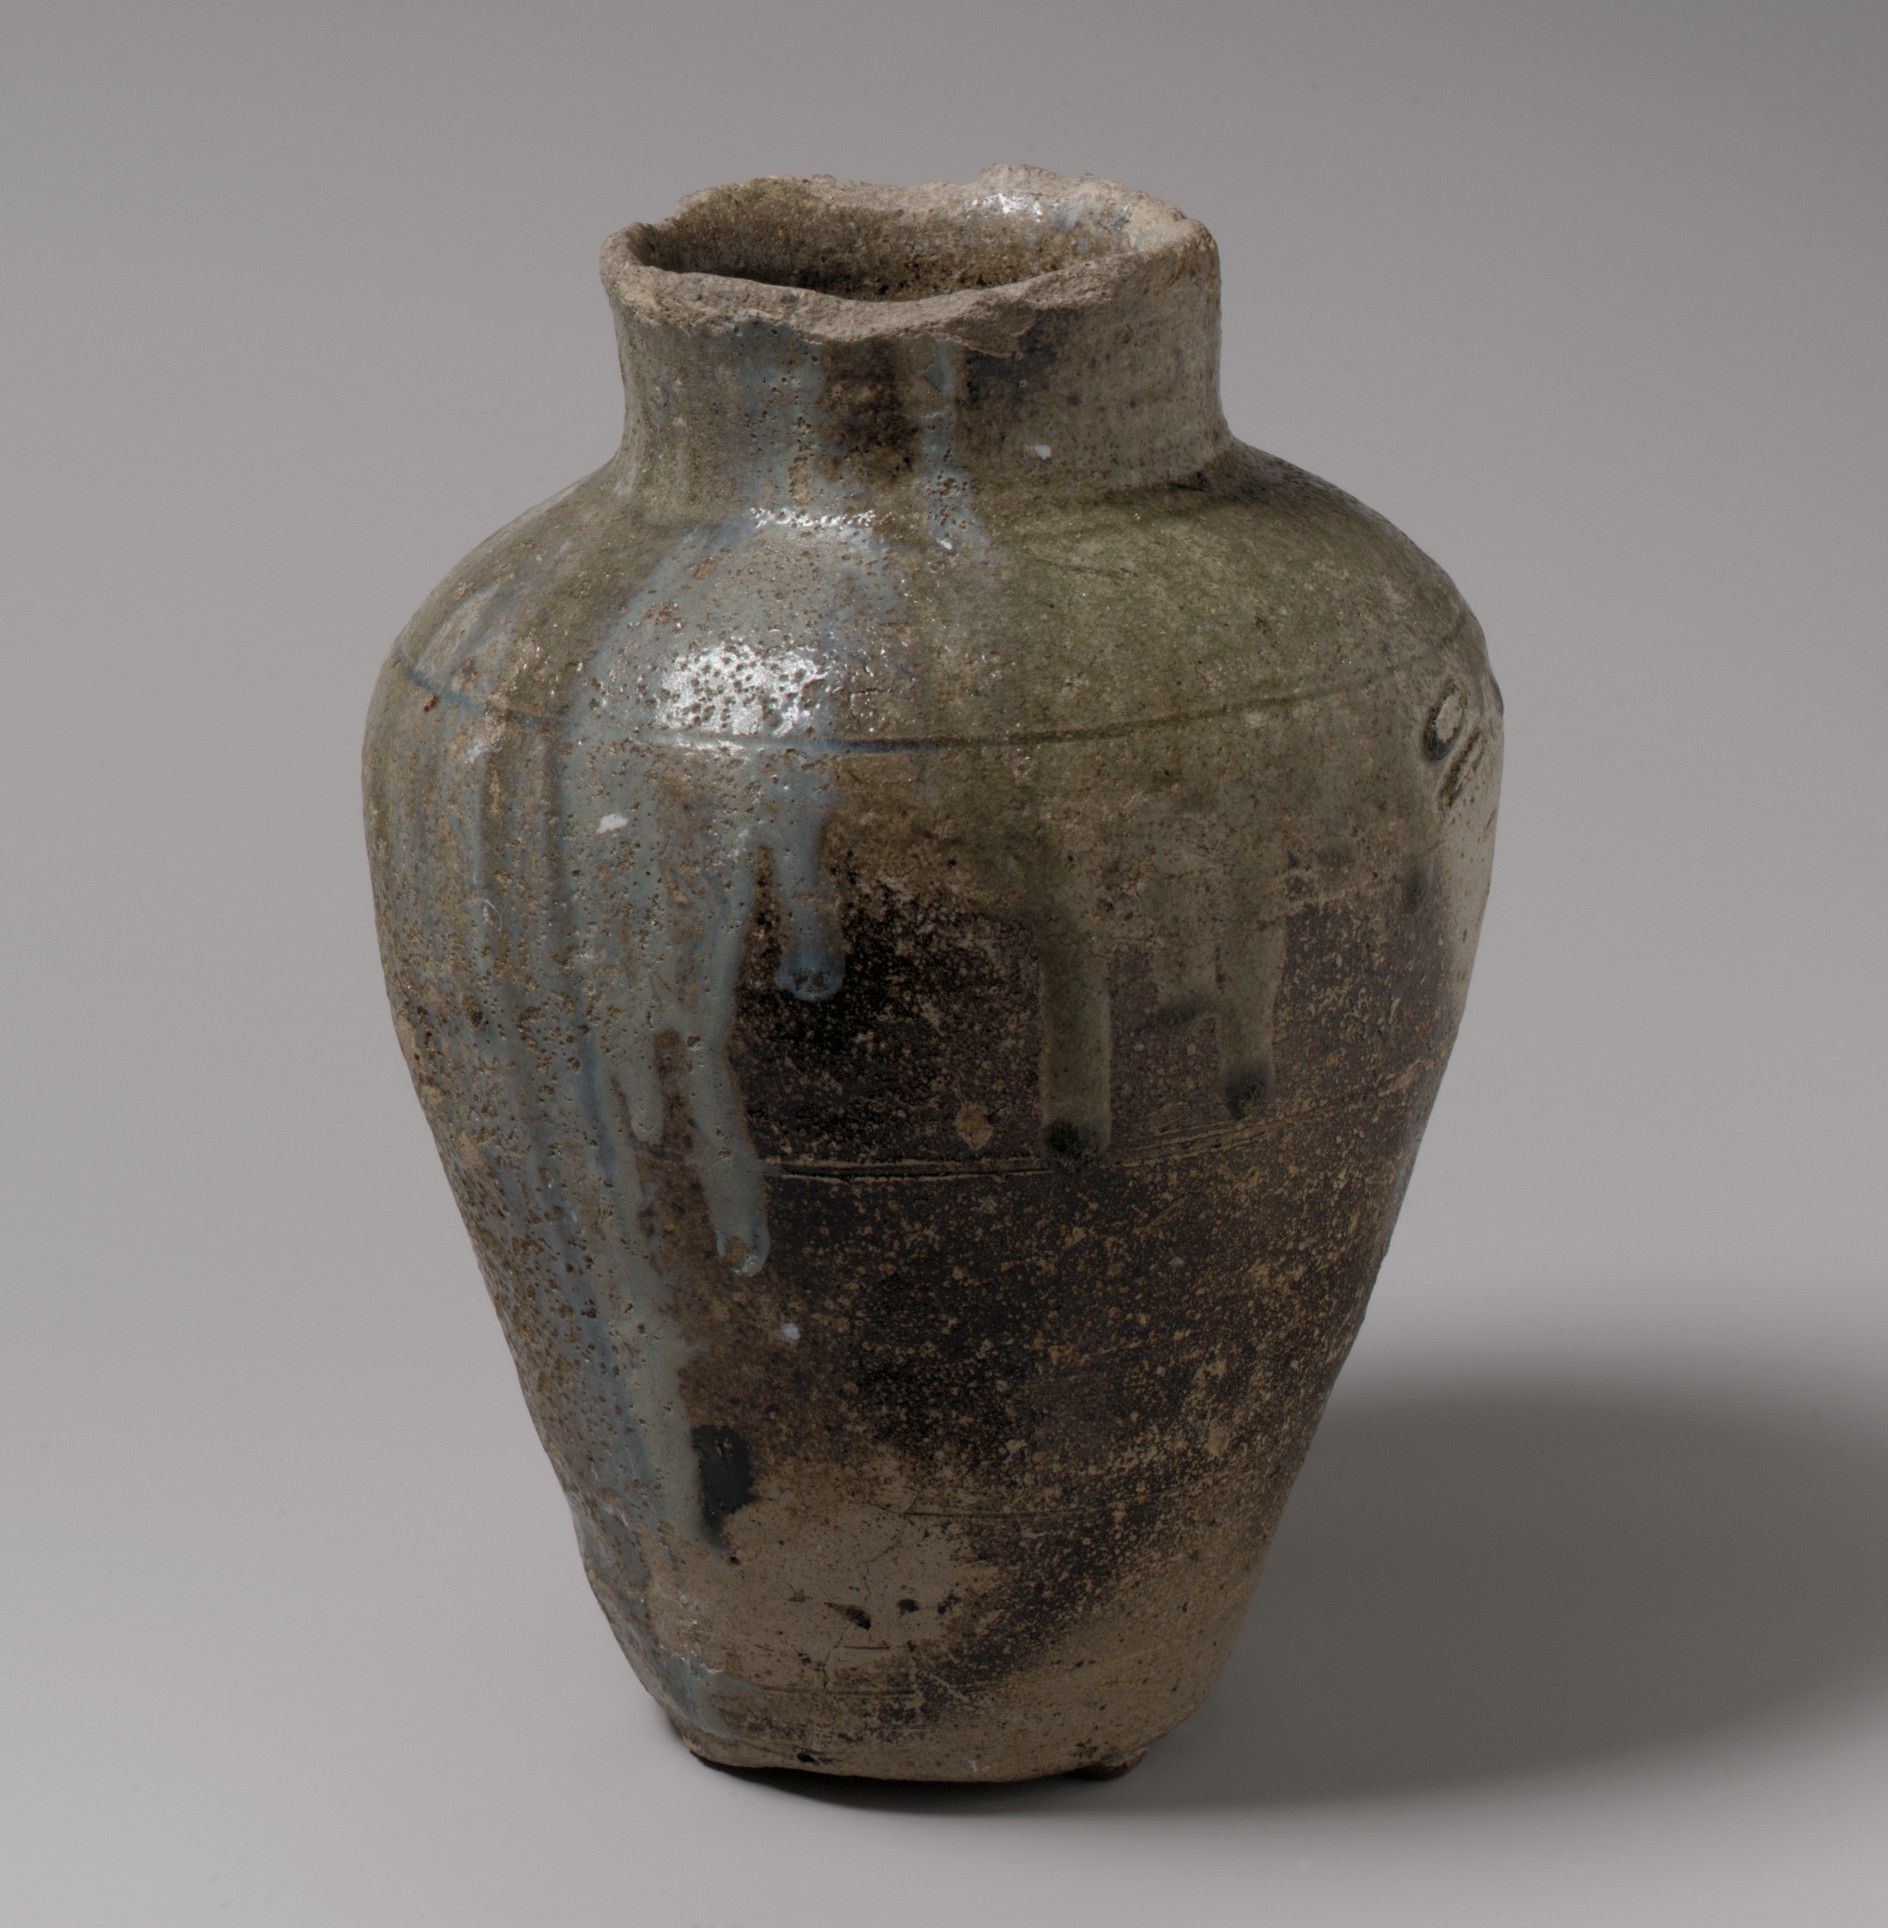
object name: jar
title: Jar for Sutra Burial (Sankinko)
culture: japanese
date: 1101-1133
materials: wood, glaze, stoneware